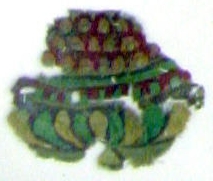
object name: textile fragment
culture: coptic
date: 401-500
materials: linen, wool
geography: egypt